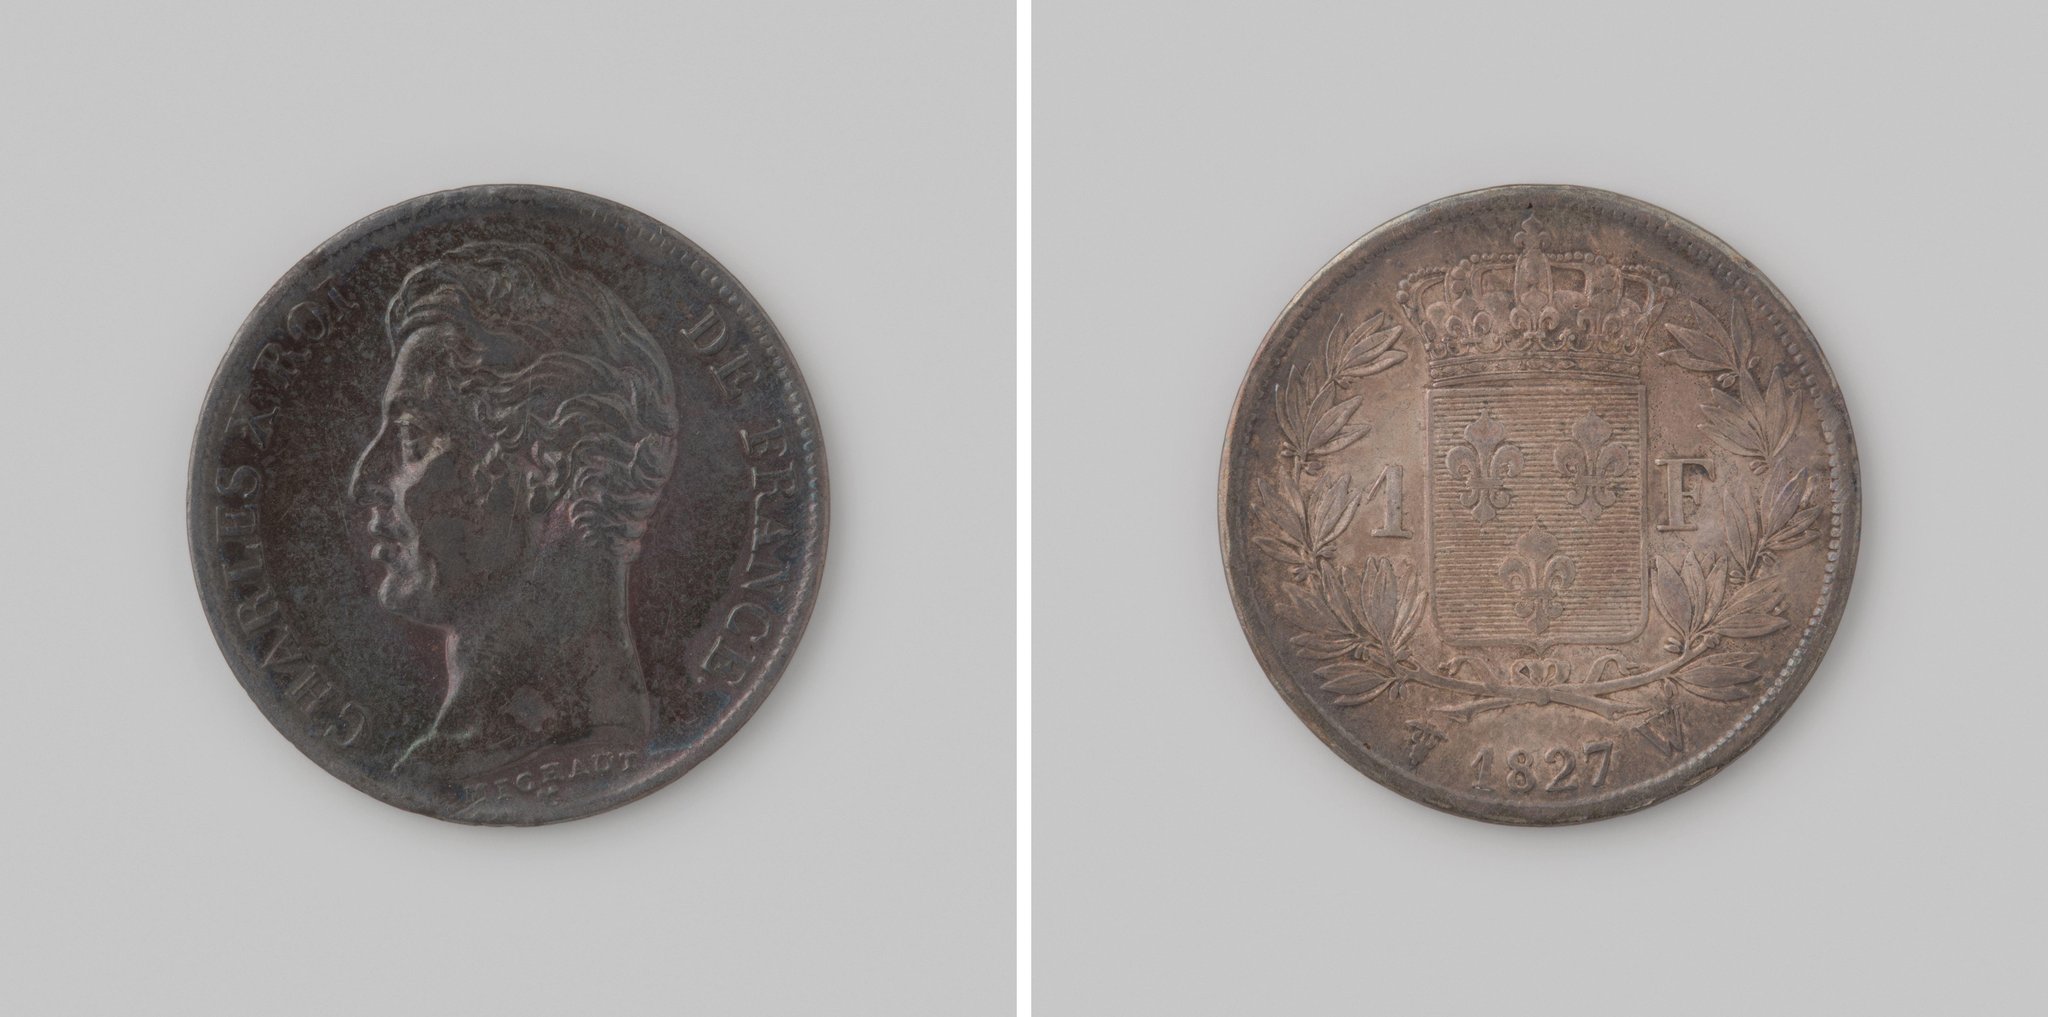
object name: coin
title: Franc uit het koninkrijk Frankrijk van Charles X, 1827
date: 1827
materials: silver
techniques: striking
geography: lille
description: Zilveren munt. Voorzijde: hoofd van de koning naar links. Keerzijde: binnen twee samengebonden lauriertakken tussen waarde-aanduiding gekroond wapenschild. Onderaan jaartal. Rechts daarvan letters VV [=Lille]. Randschrift.